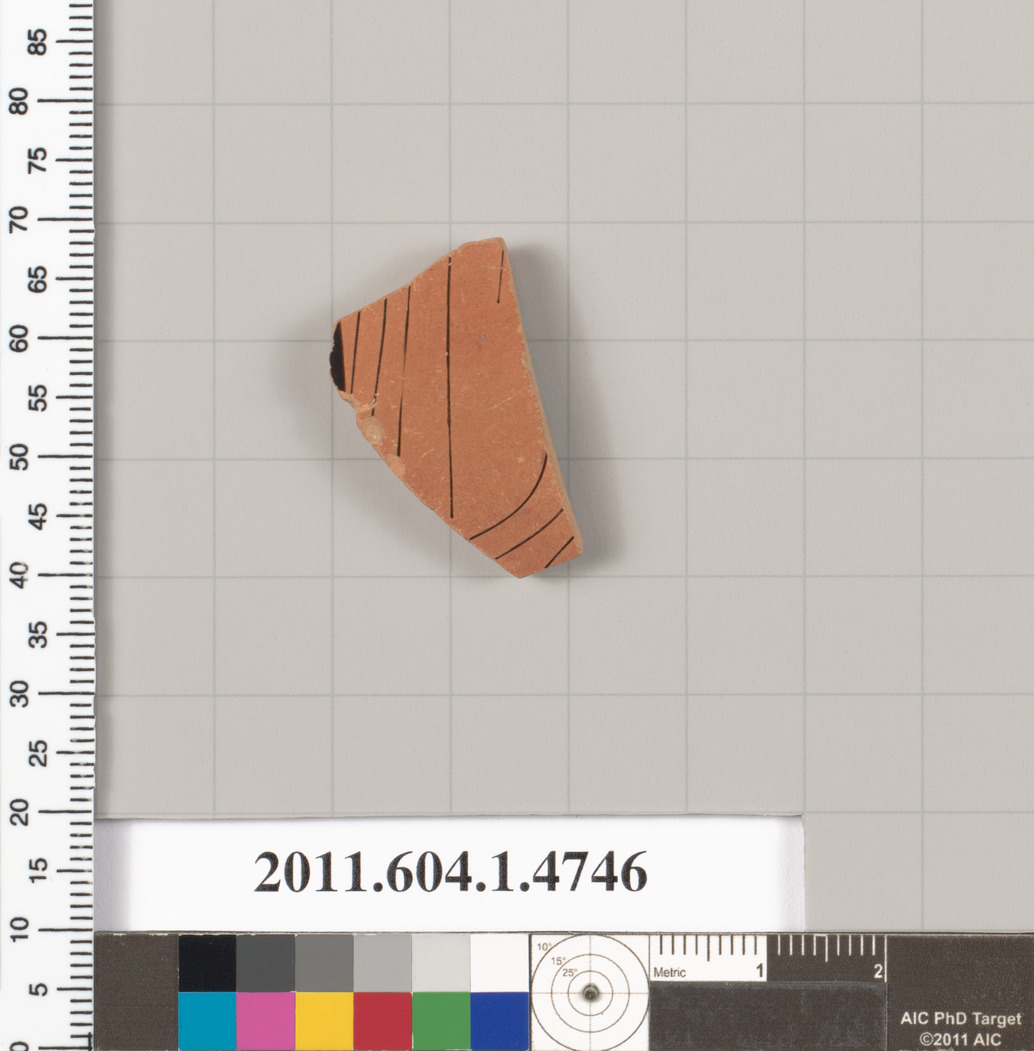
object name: kylix fragment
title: Terracotta fragment of a kylix (drinking cup)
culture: greek, attic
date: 475-451 BCE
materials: terracotta